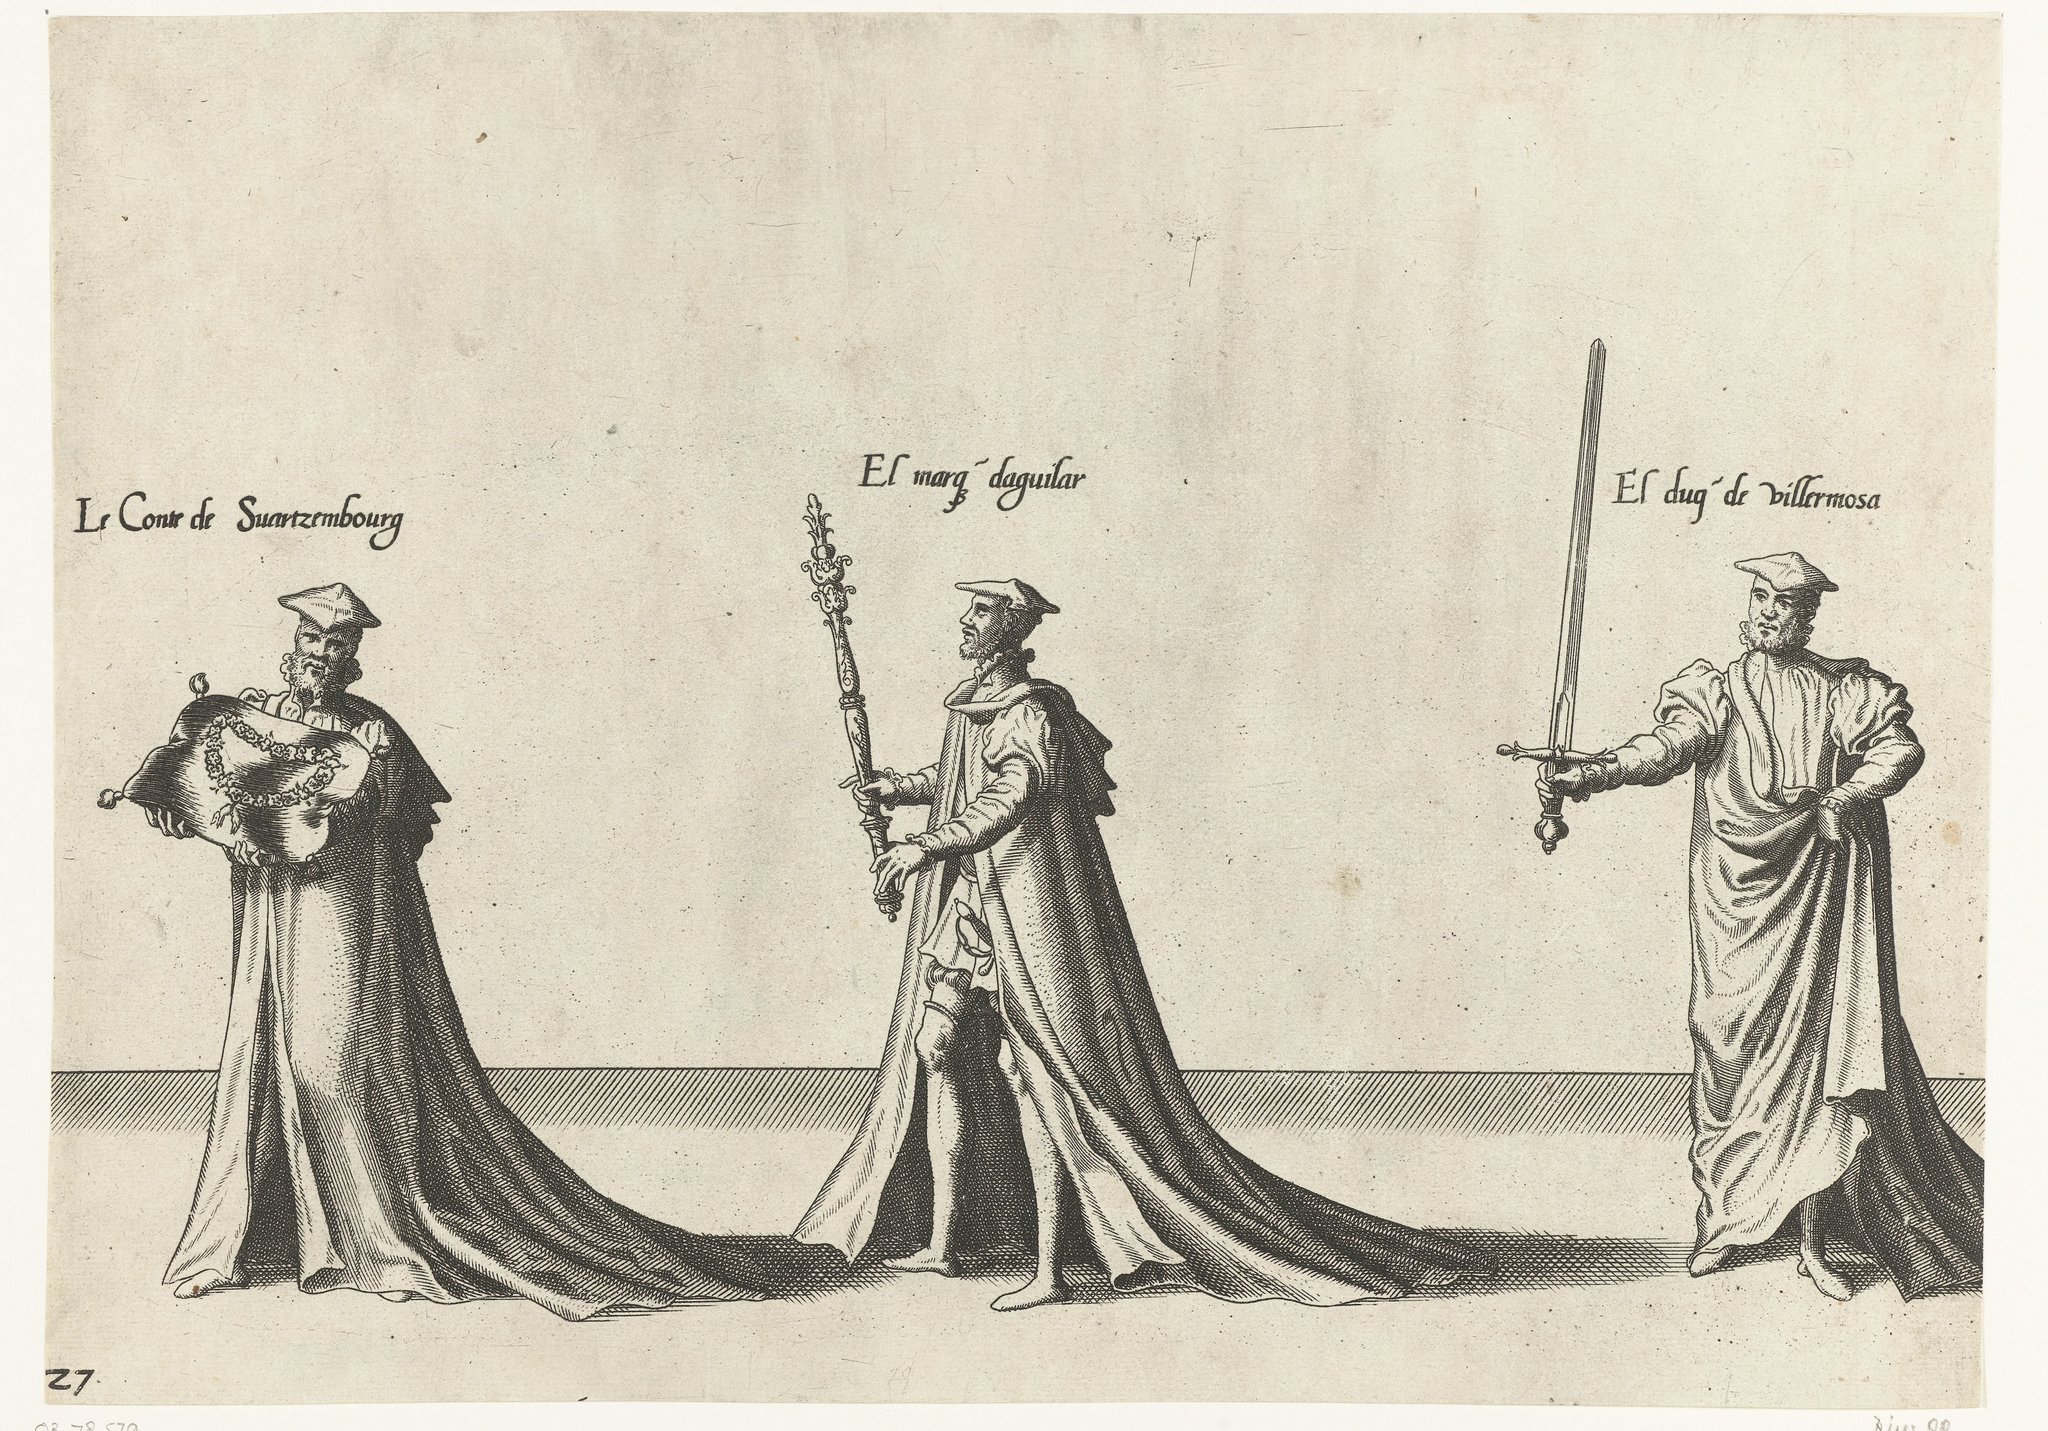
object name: print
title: Deel van de optocht, nr. 27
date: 1559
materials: paper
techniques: engraving, etching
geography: southern netherlands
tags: ghent, charles v (holy roman emperor and king of spain), cortege, funeral procession, brussels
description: Drie deelnemers aan de optocht, met zich meedragend de ketting met de orde van het Gulden Vlies, de scepter en het zwaard. Onderdeel van de prentreeks van de Begrafenisoptocht van keizer Karel V op 29 december 1558 te Brussel.